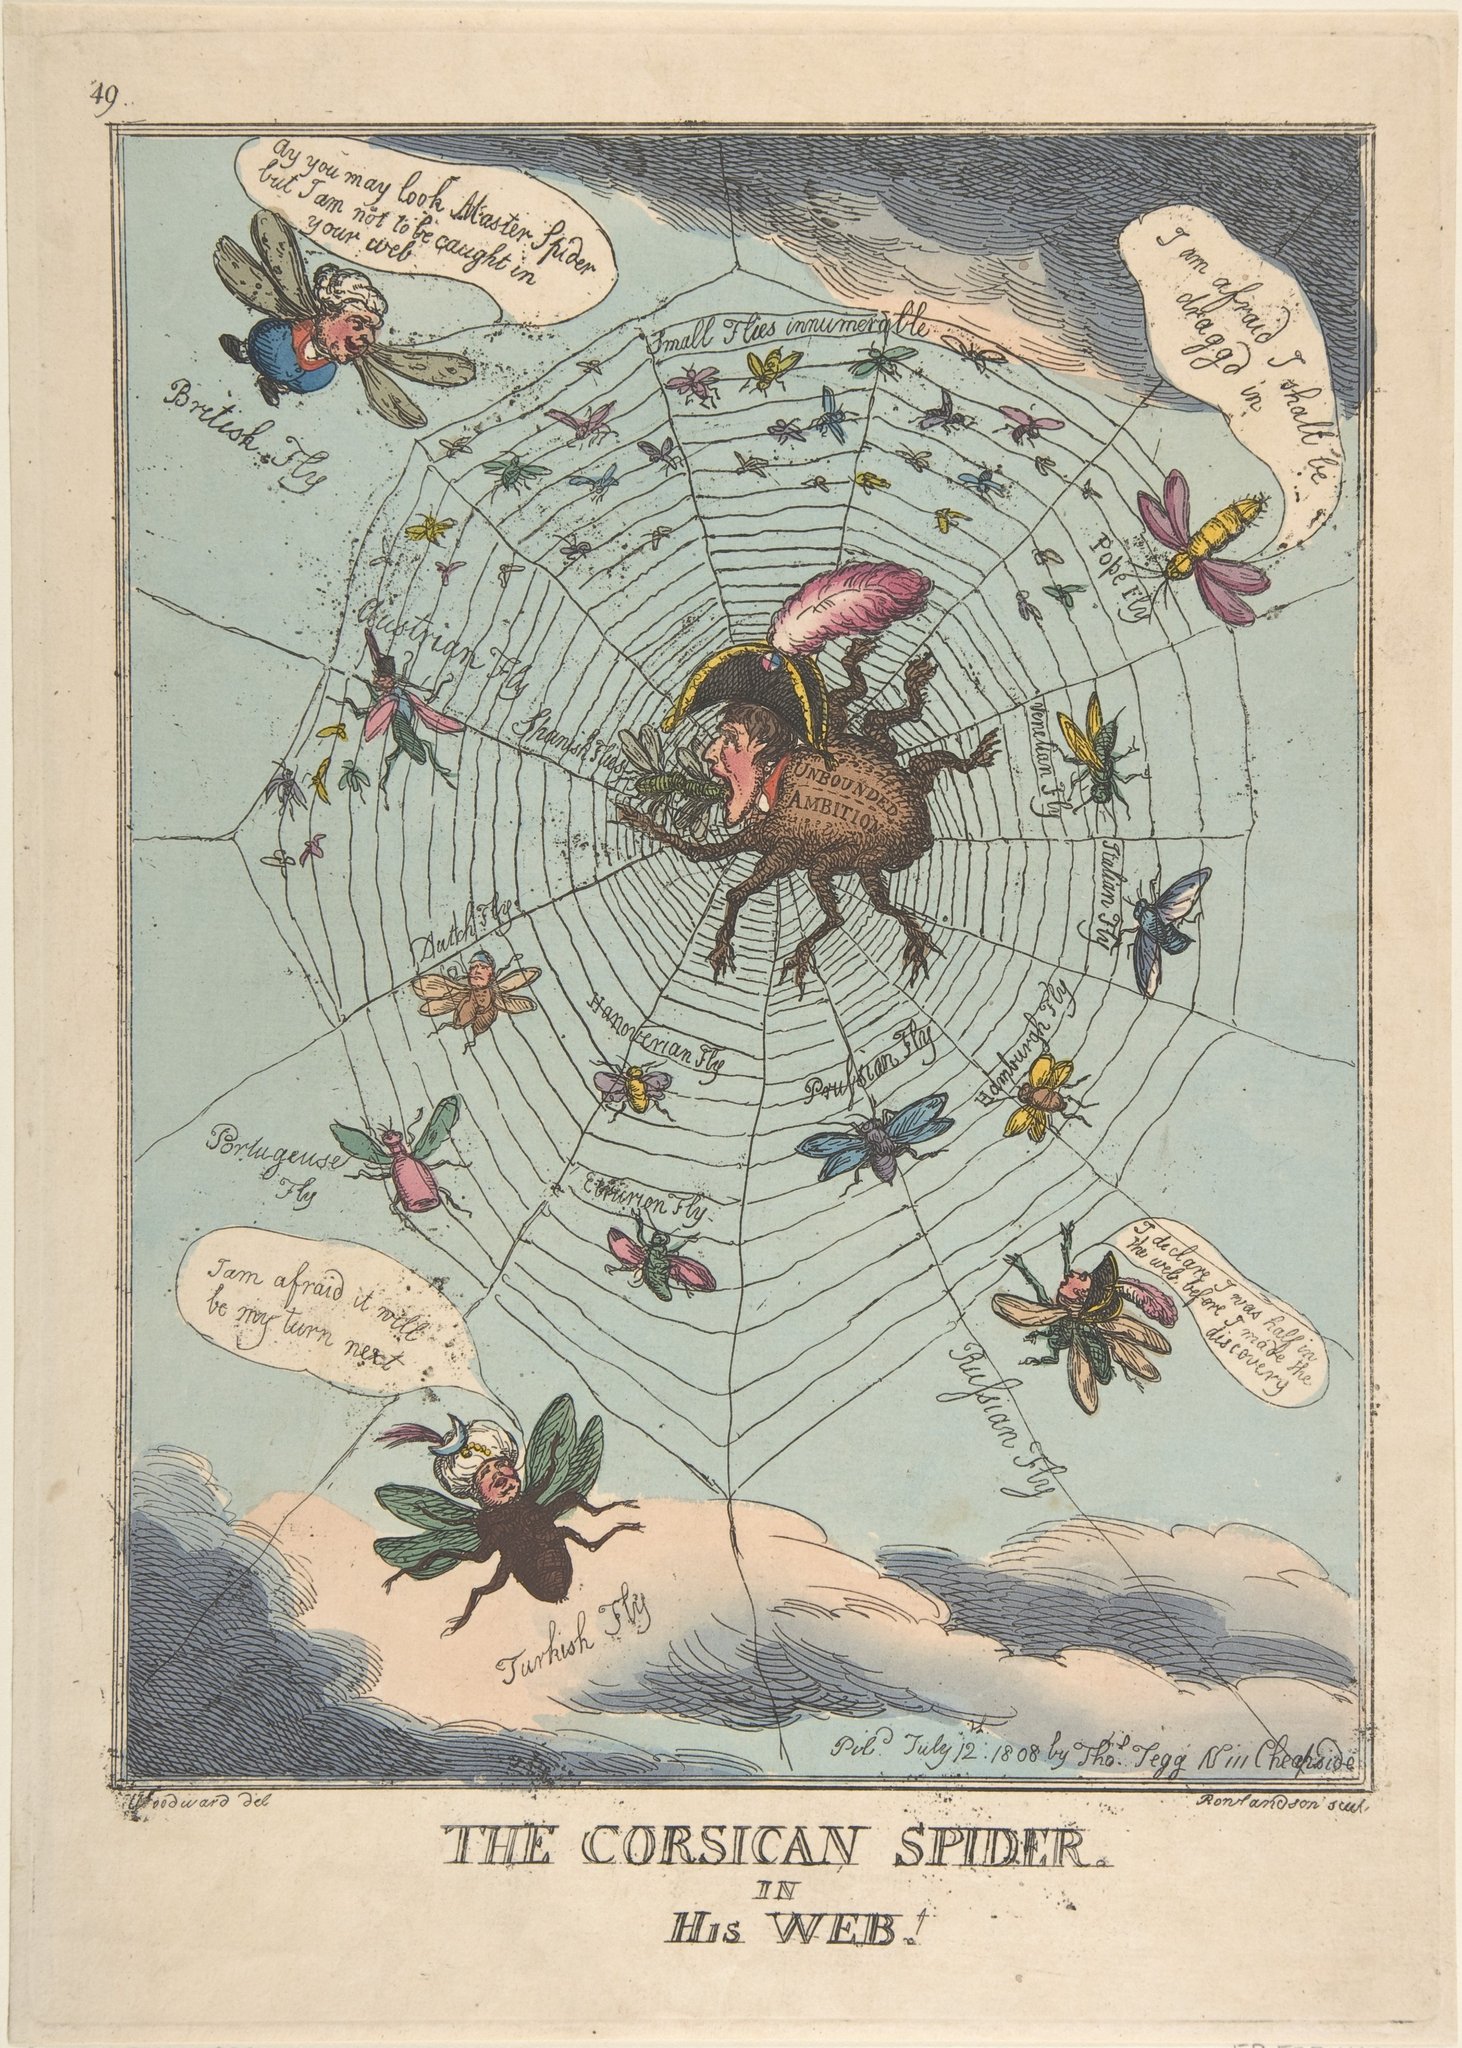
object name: print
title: The Corsican Spider in His Web!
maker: thomas rowlandson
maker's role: artist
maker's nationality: british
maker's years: 1757-1827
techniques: etching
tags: satire,napoleon i,insects,spiders,politics